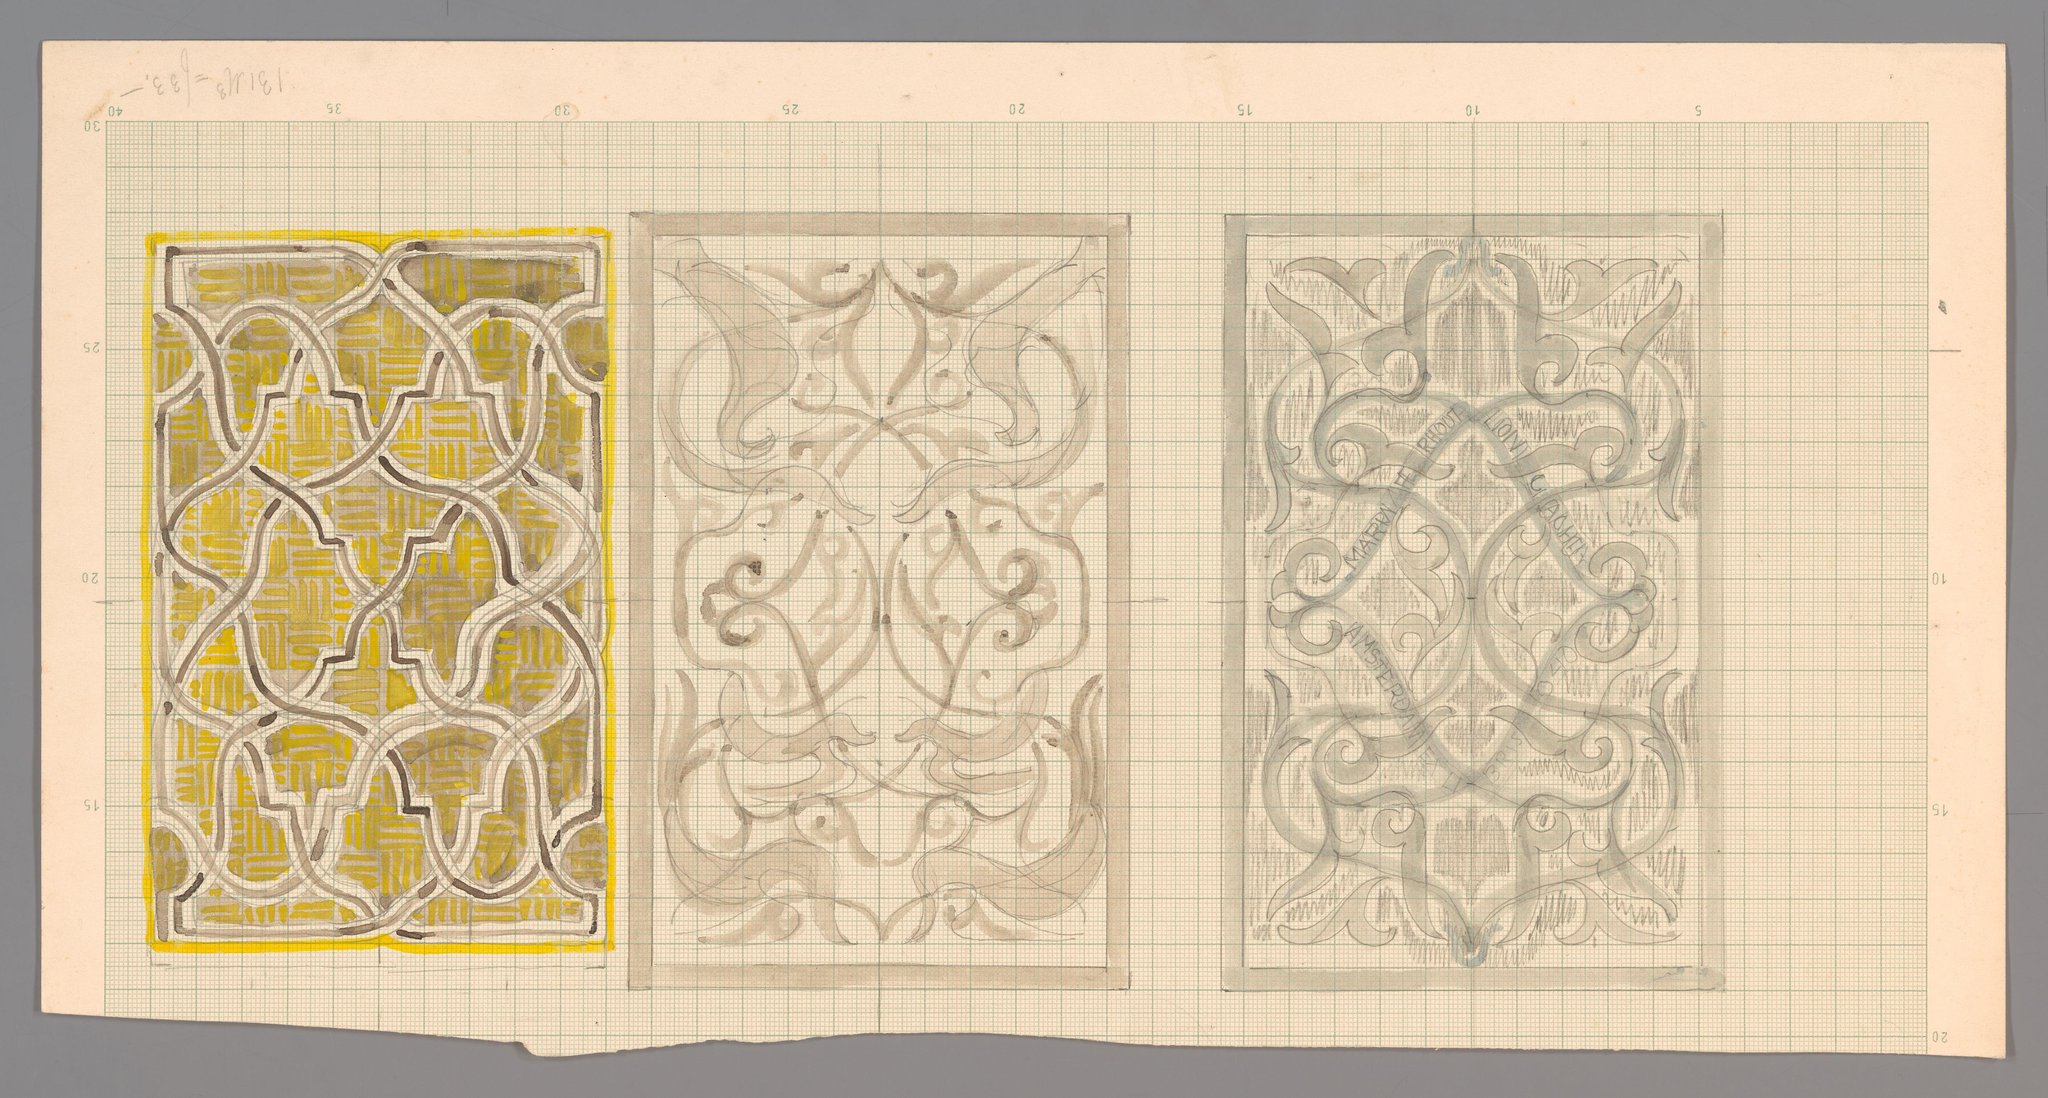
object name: design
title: Drie ontwerpen voor een ex libris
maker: carel adolph lion cachet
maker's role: draughtsman, print maker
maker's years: 1864-1945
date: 1940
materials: pencil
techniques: brush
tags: ex-libris